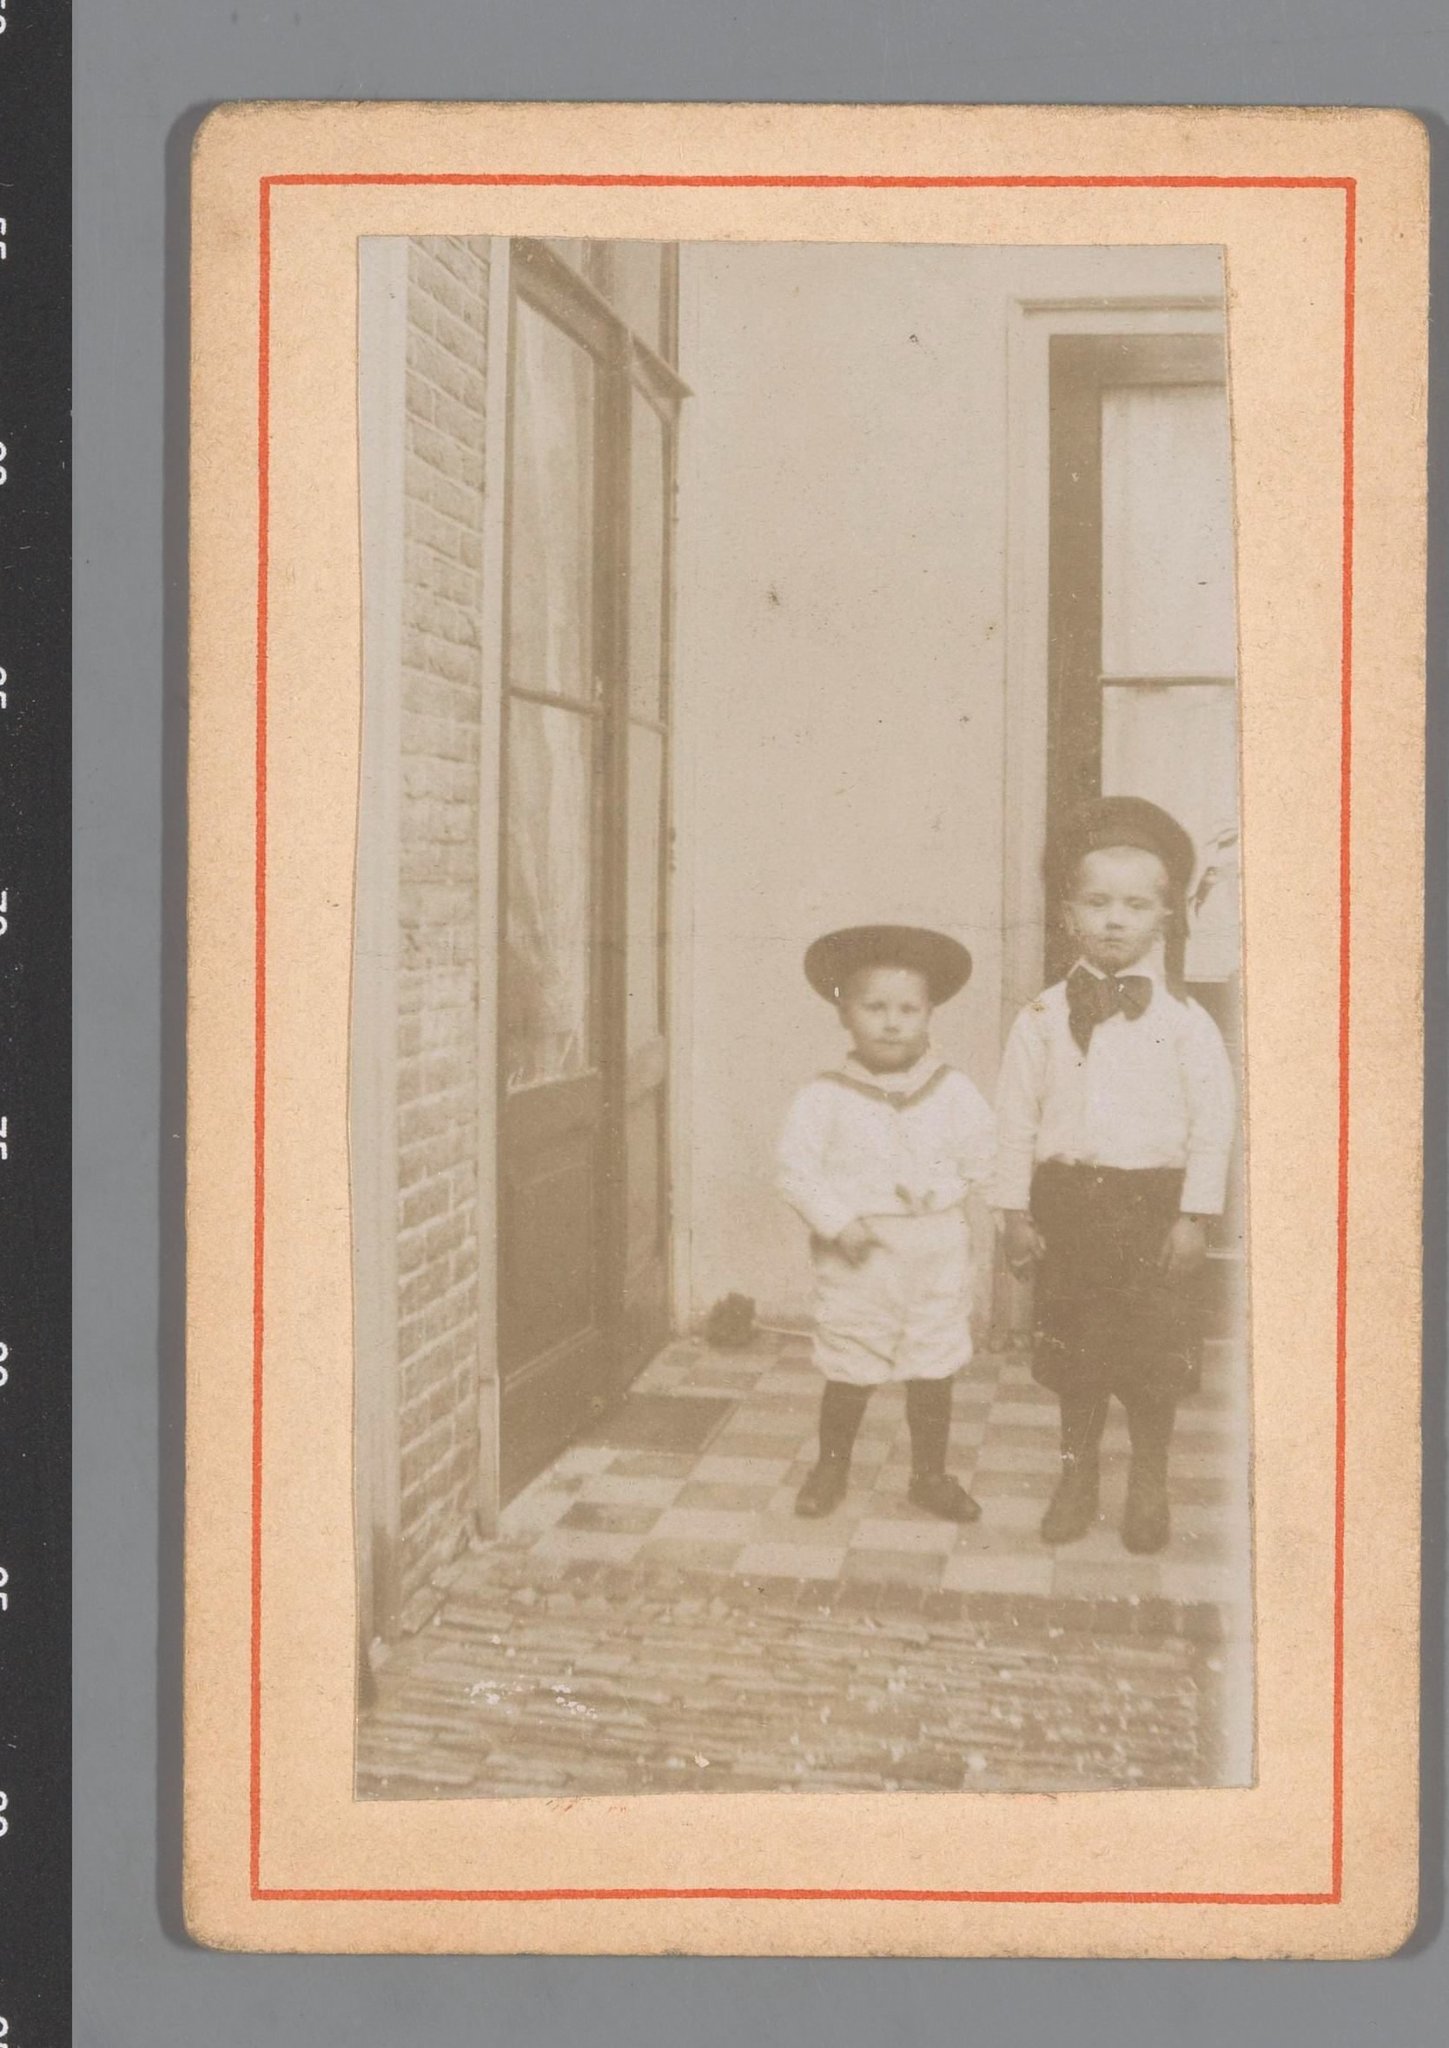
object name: carte de visite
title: Portret van twee onbekende kinderen op een binnenplaats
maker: Anonymous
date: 1860-1900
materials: cardboard, paper, photographic support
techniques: collodion silver print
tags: courtyard, child (at home)